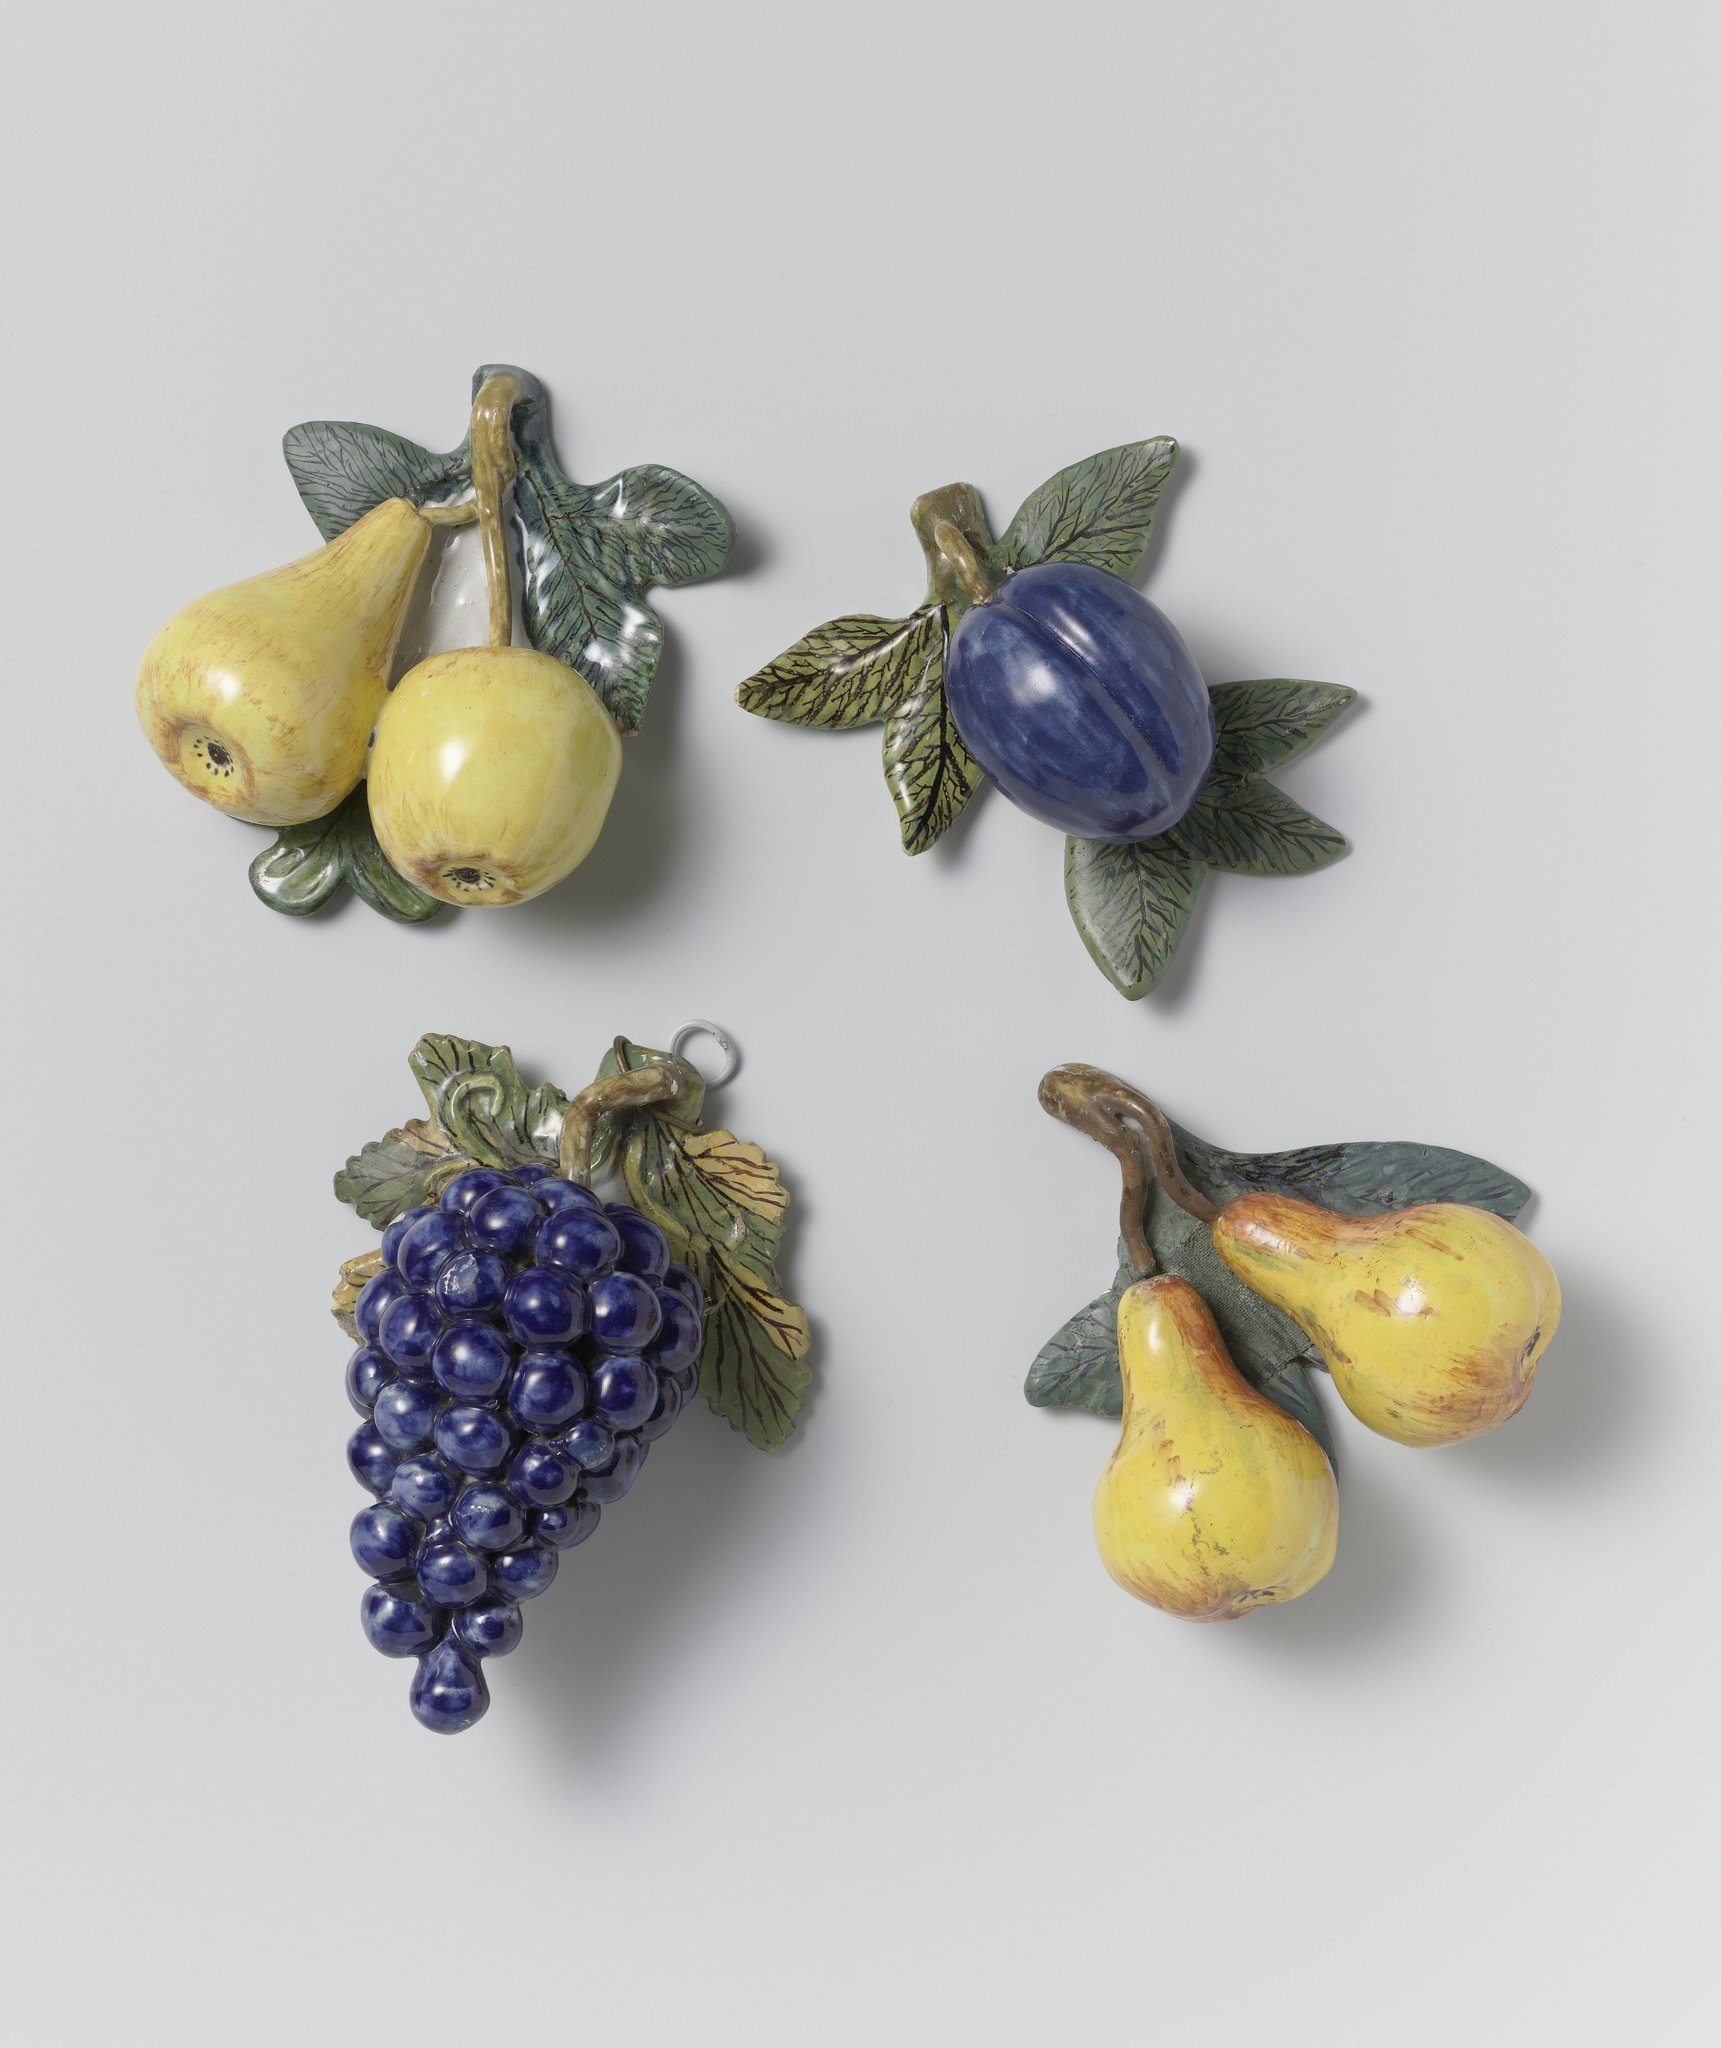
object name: artificial fruit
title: Druiventros van faience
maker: Anonymous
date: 1750-1775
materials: faience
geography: delft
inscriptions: collector's mark: ‘onleesbaar’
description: Kunstfruit van faience, voorstellende een tros druiven op een druivenblad. Veelkleurig beschilderd.